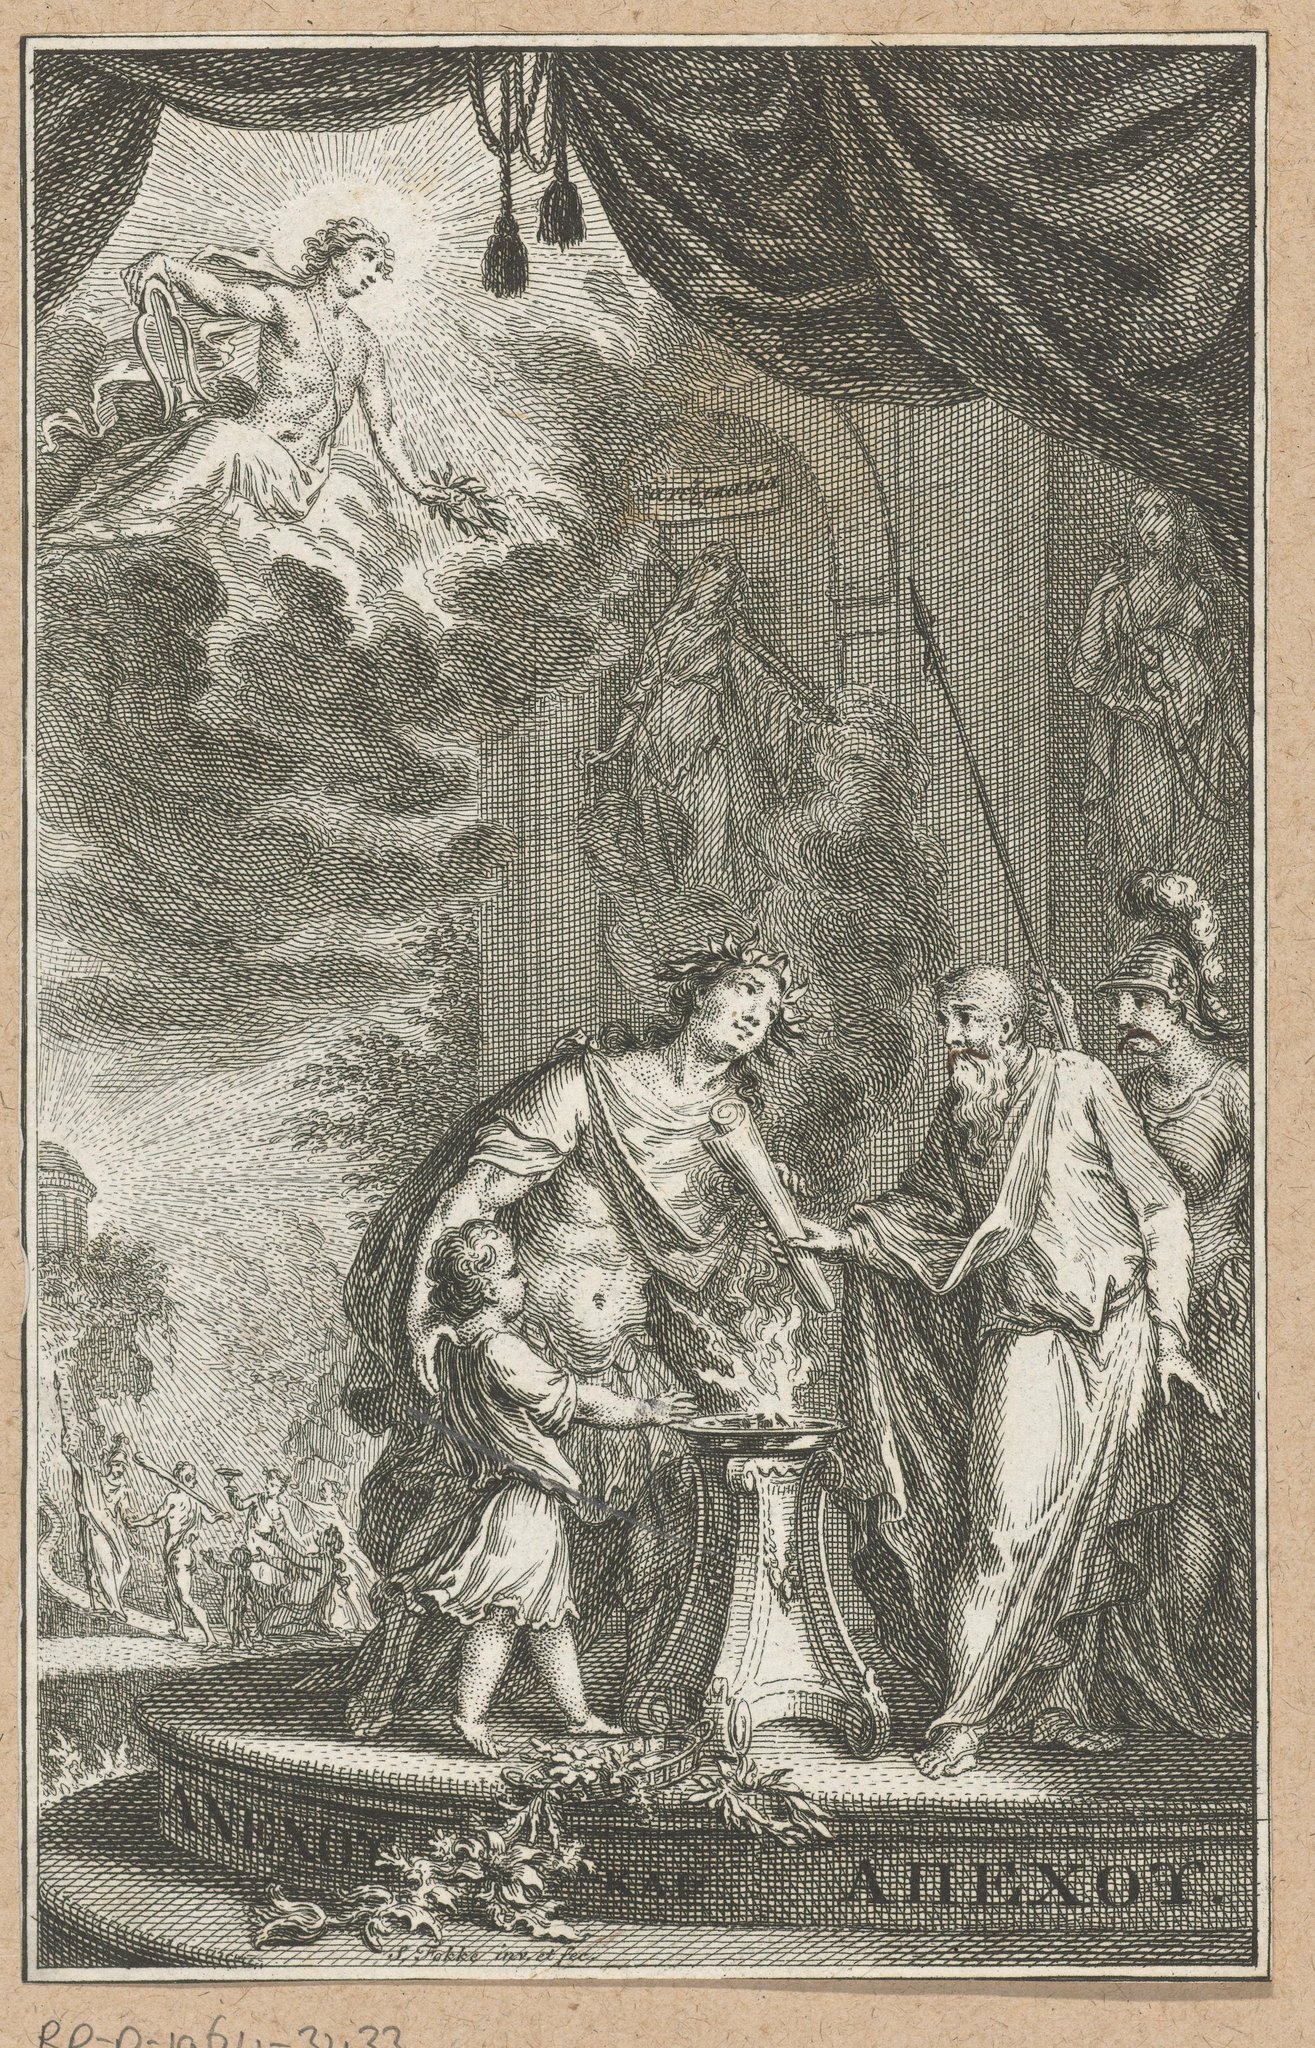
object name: print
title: Drie figuren rond een brandende offerzuil in een tempel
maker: simon fokke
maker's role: draughtsman, print maker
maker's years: 1712-1784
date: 1759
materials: paper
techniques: etching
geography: amsterdam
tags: specific aspects, allegorical aspects of apollo; apollo as patron, temple, shrine ~ greek religion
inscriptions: collector's mark: Lugt 2228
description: Een kale man met baard overhandigt een papierrol aan een gelauwerde man. Naast hem staat een jongetje dat zijn hand voor het vuur op de offerzuil houdt. Het drietal is in antieke kledij gehuld. Vanuit de lucht kijkt Apollo met lauwerkrans op hen neer.